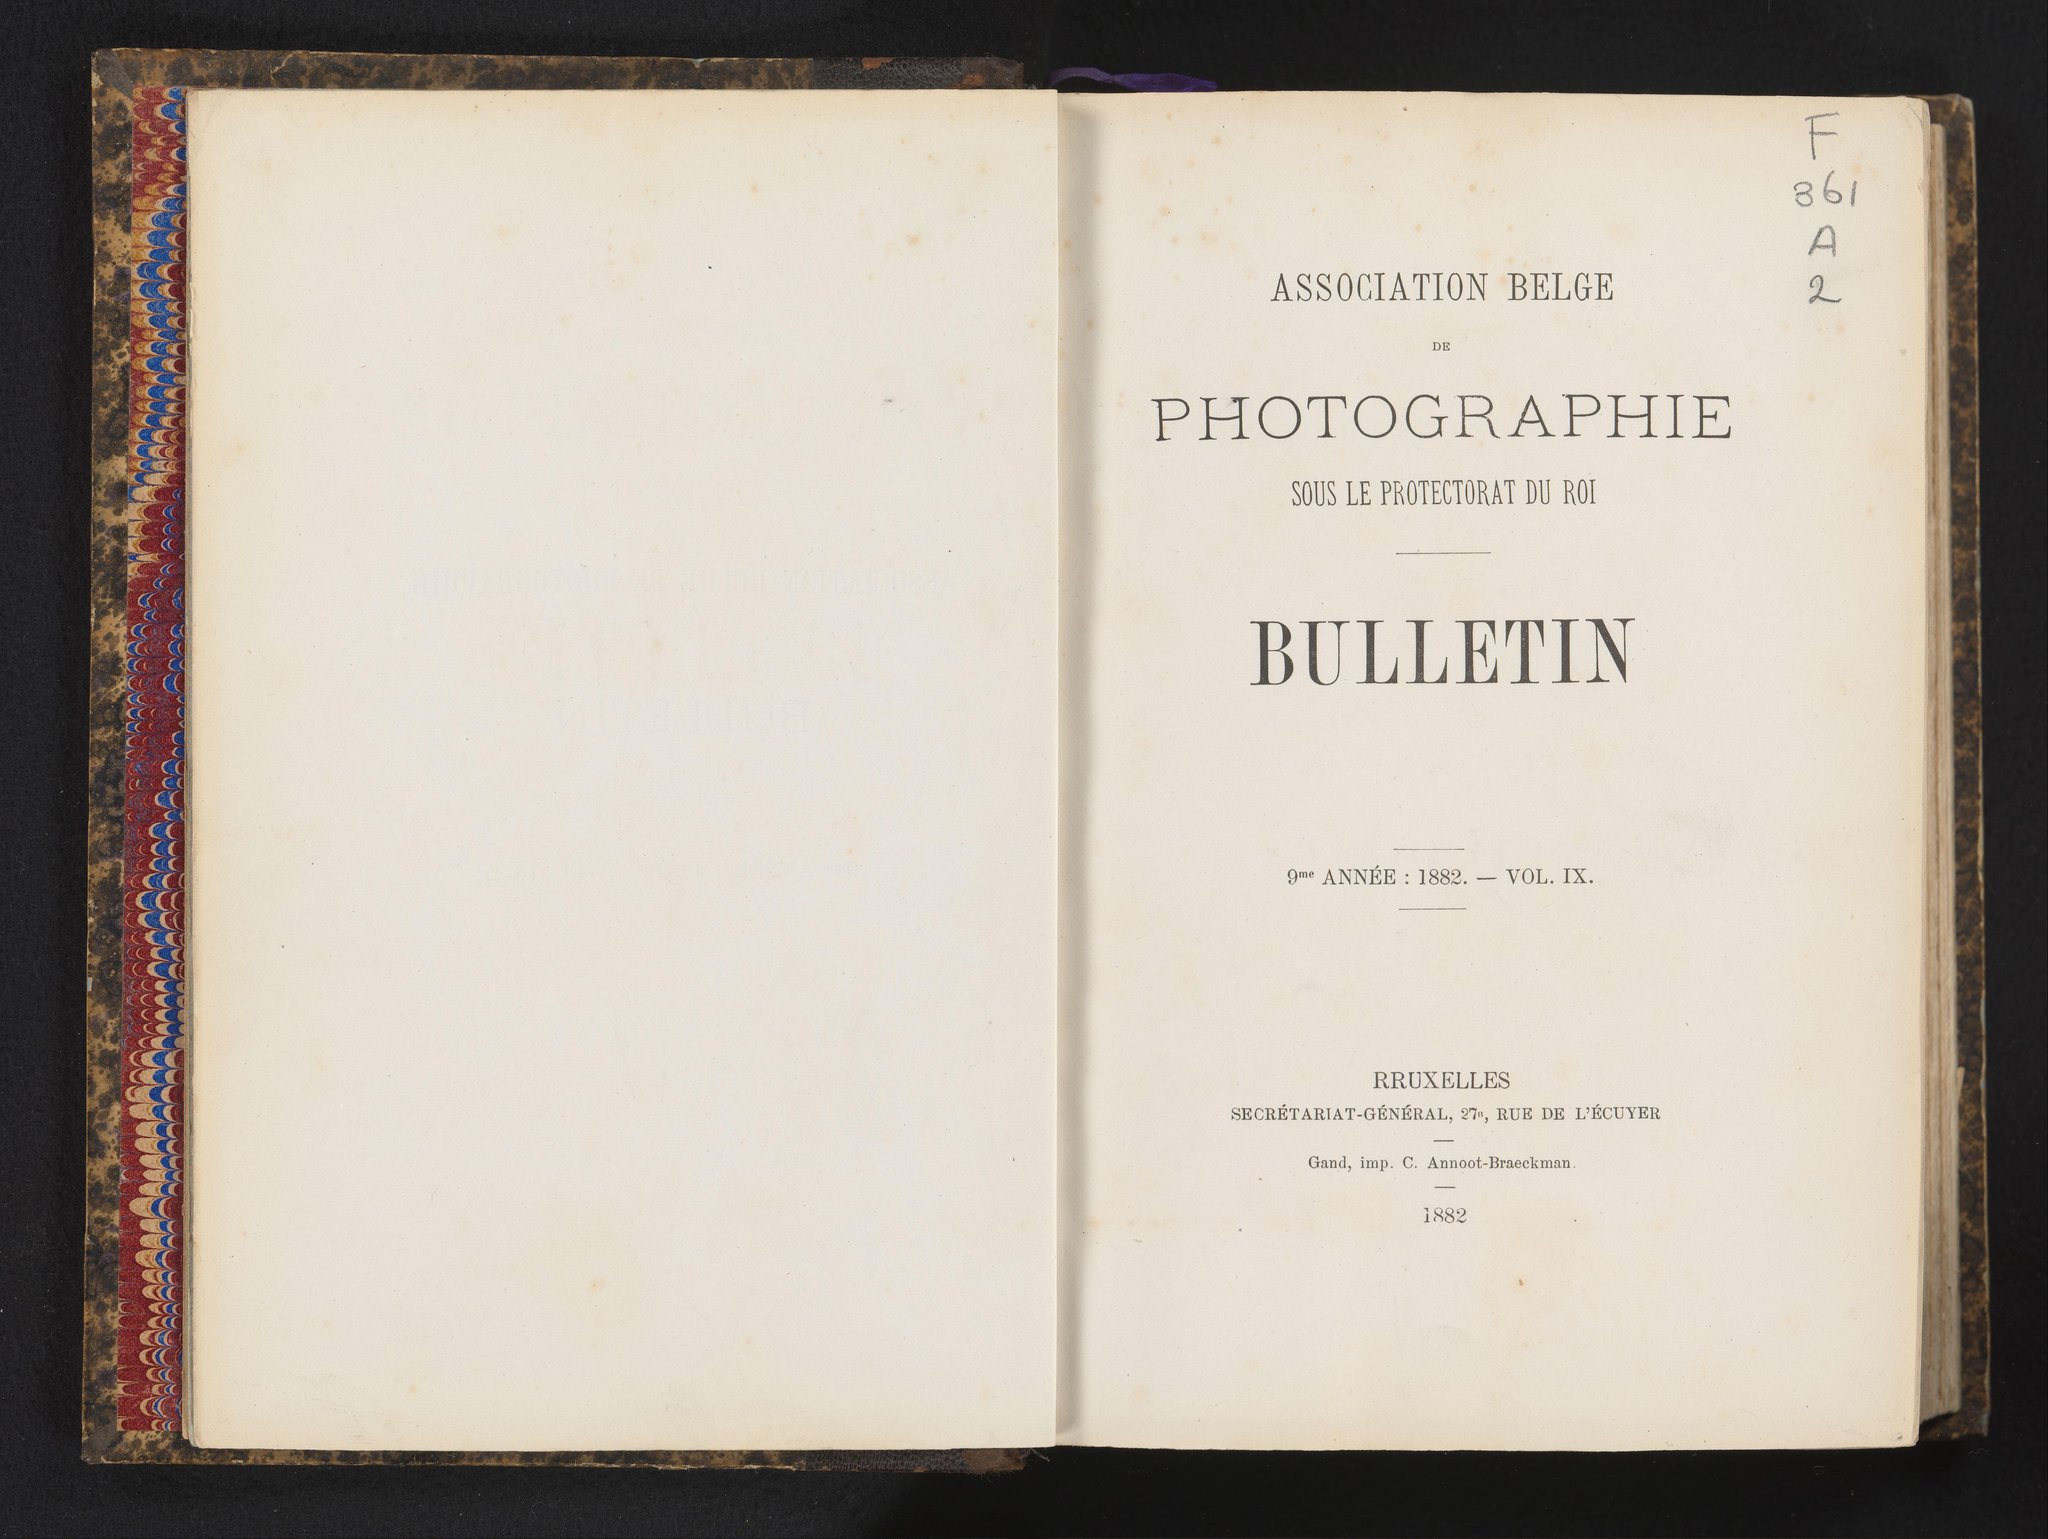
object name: book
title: Bulletin / Association belge de photographie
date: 1882-1883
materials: cardboard, leather, paper, photographic support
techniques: marbled paper, photograph, photoaquatint, platinum process, printing, woodburytype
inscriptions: annotation: ‘APR/1997’